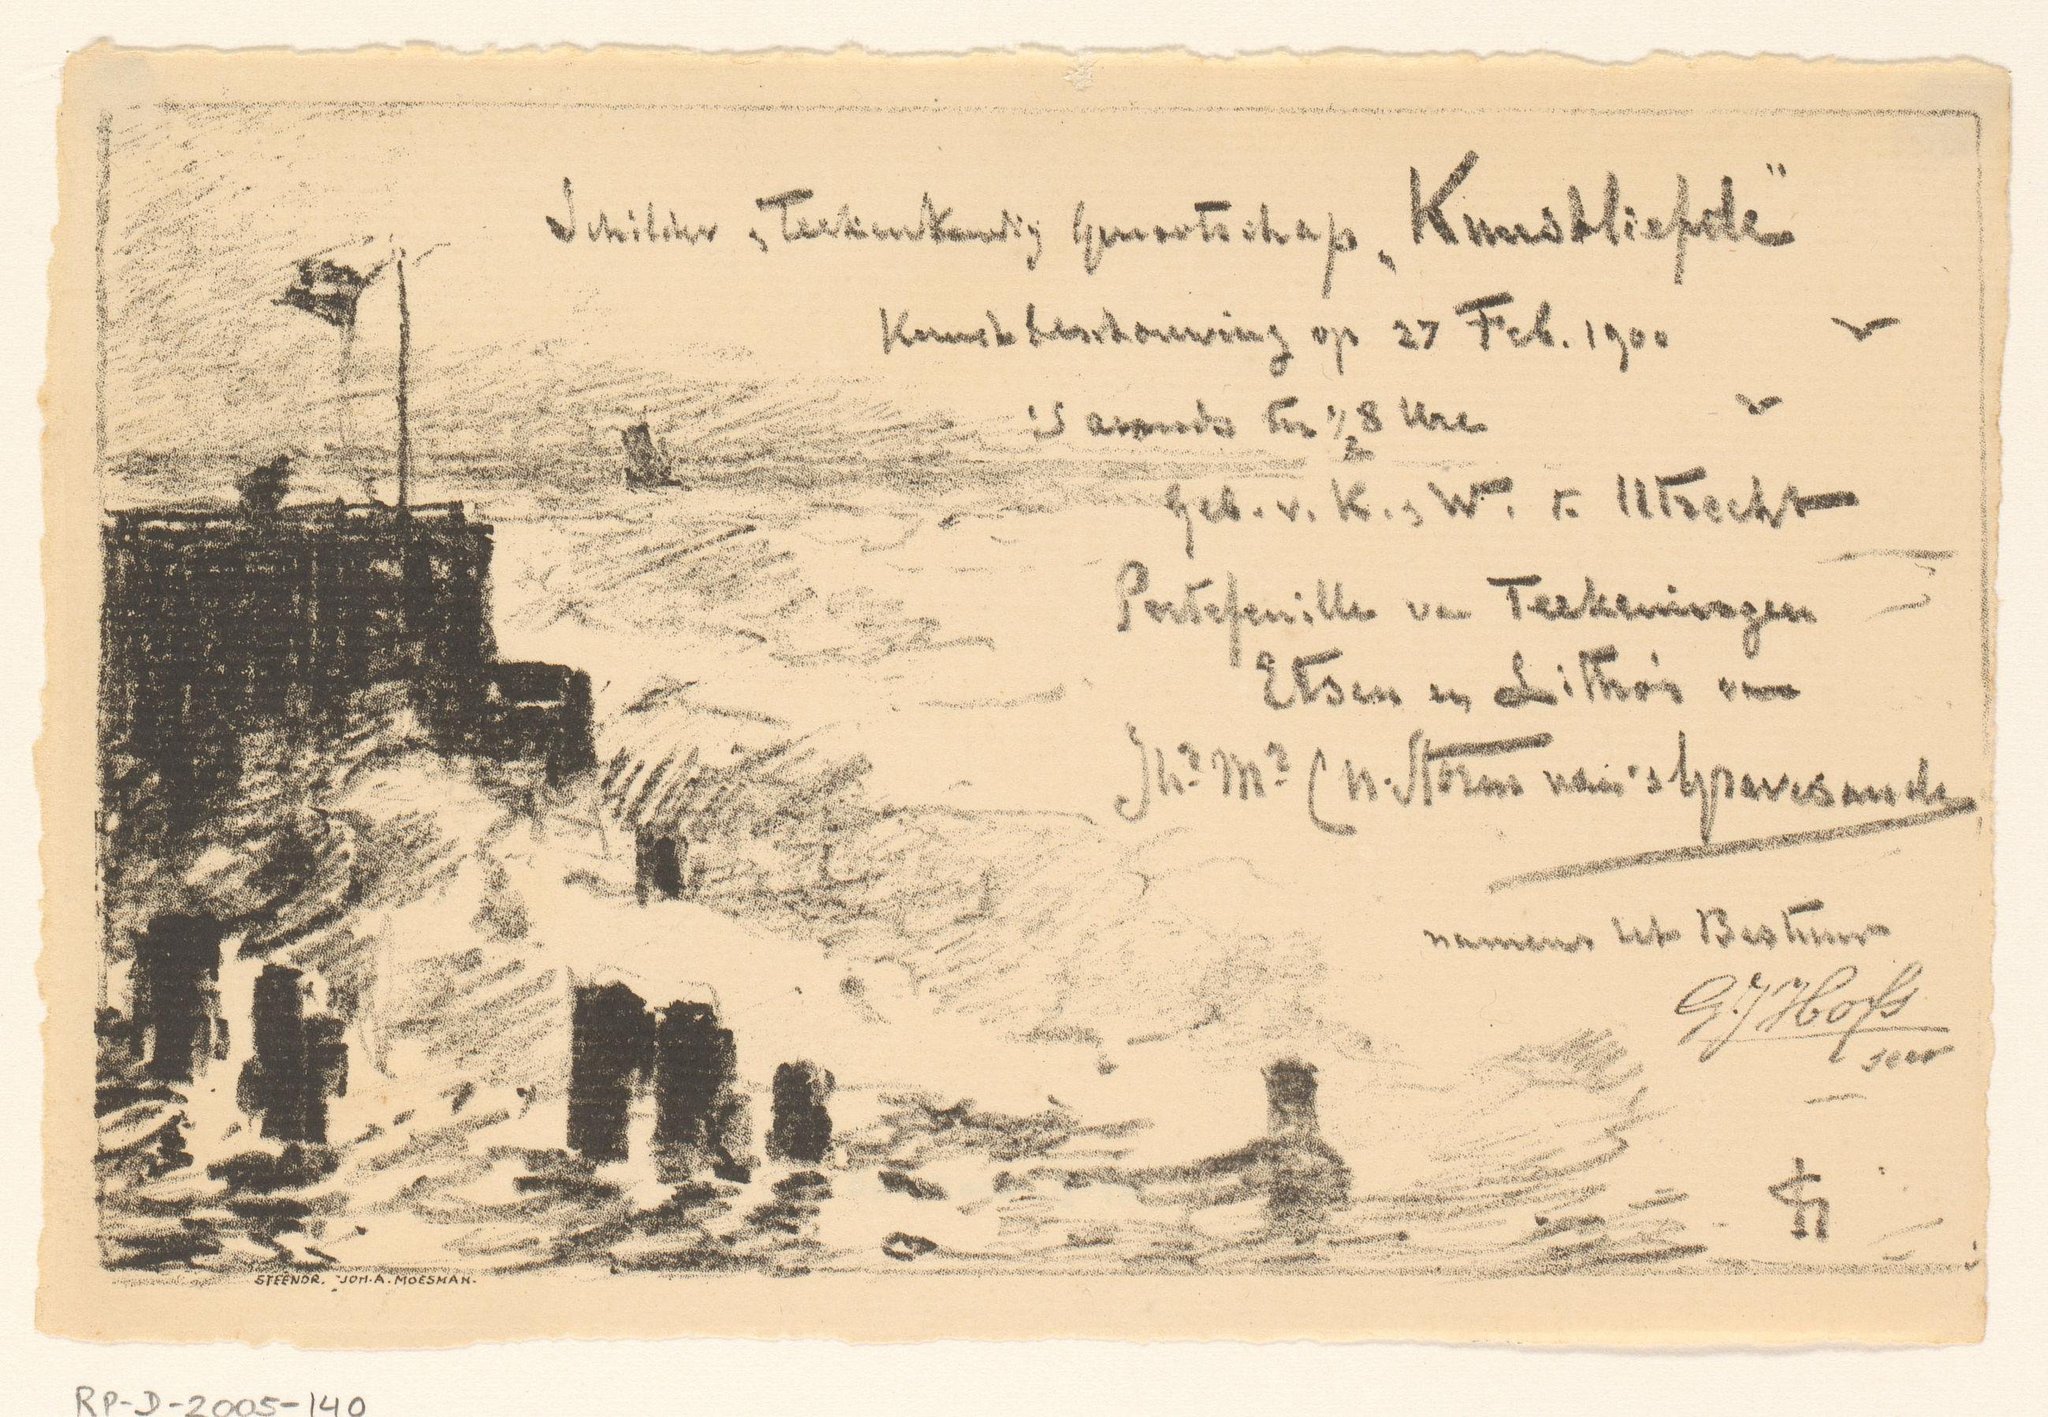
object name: print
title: Uitnodiging van Schilder- en Teekenkundig Genootschap "Kunstliefde" voor een kunstbeschouwing, 27 februari 1900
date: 1900-1902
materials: paper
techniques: lithograph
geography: utrecht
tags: the hague, print maker, draughtsman, carel nicolaas storm van 's-gravesande, criticizing and discussing art, art criticism, wave, circle, club of artists, collecting and exhibiting products of the fine arts, surf, breakers, pier, quay, wharf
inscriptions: collector's mark: Lugt 2228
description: Golven aan de steiger. Uitnodiging van Schilder- en Teekenkundig Genootschap "Kunstliefde" voor een kunstbeschouwing op 27 februari 1900 van de portefeuille etsen en litho's van Jhr. Mr. C.N. Storm van 's-Gravesande. In het Gebouw voor Kunsten en Wetenschappen te Utrecht.